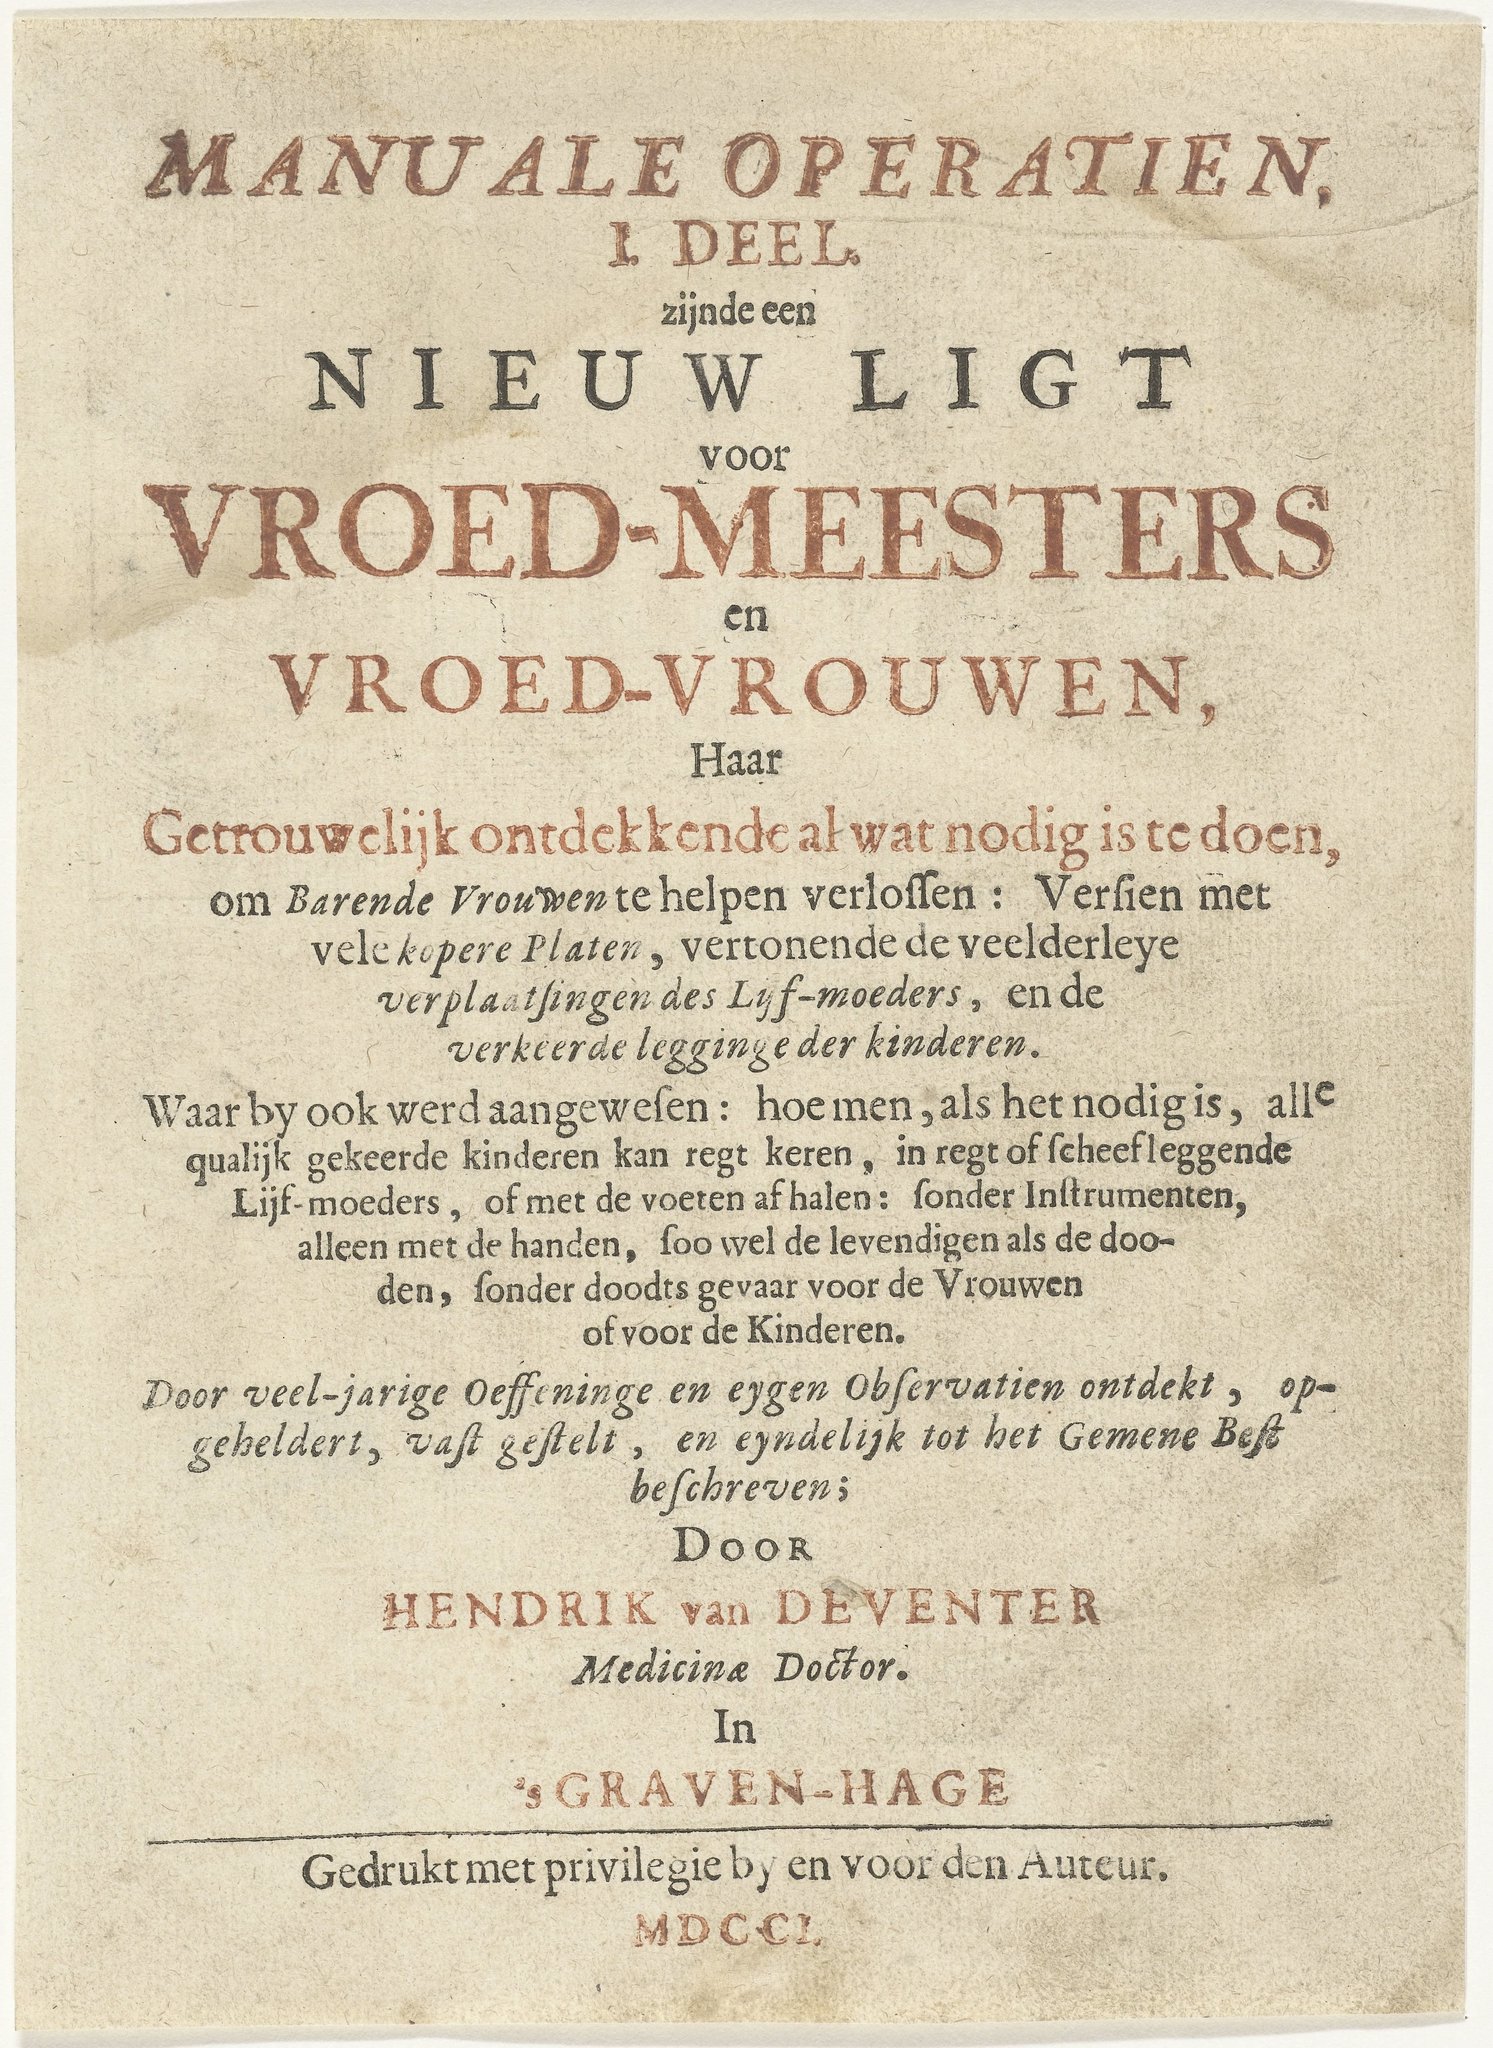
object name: text sheet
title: Titelpagina voor: Manuale operatien, I. deel. zijnde een nieuw ligt voor vroed-meesters en vroed-vrouwen, Den Haag 1701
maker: hendrik van deventer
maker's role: geneeskundige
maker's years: 1651-1724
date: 1701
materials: paper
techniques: letterpress printing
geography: the hague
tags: title-page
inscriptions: collector's mark: Lugt 2760, collector's mark: Lugt 2228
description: Titelpagina voor: Hendrik van Deventer, Manuale operatien, I. deel. zijnde een nieuw ligt voor vroed-meesters en vroed-vrouwen, Den Haag 1701